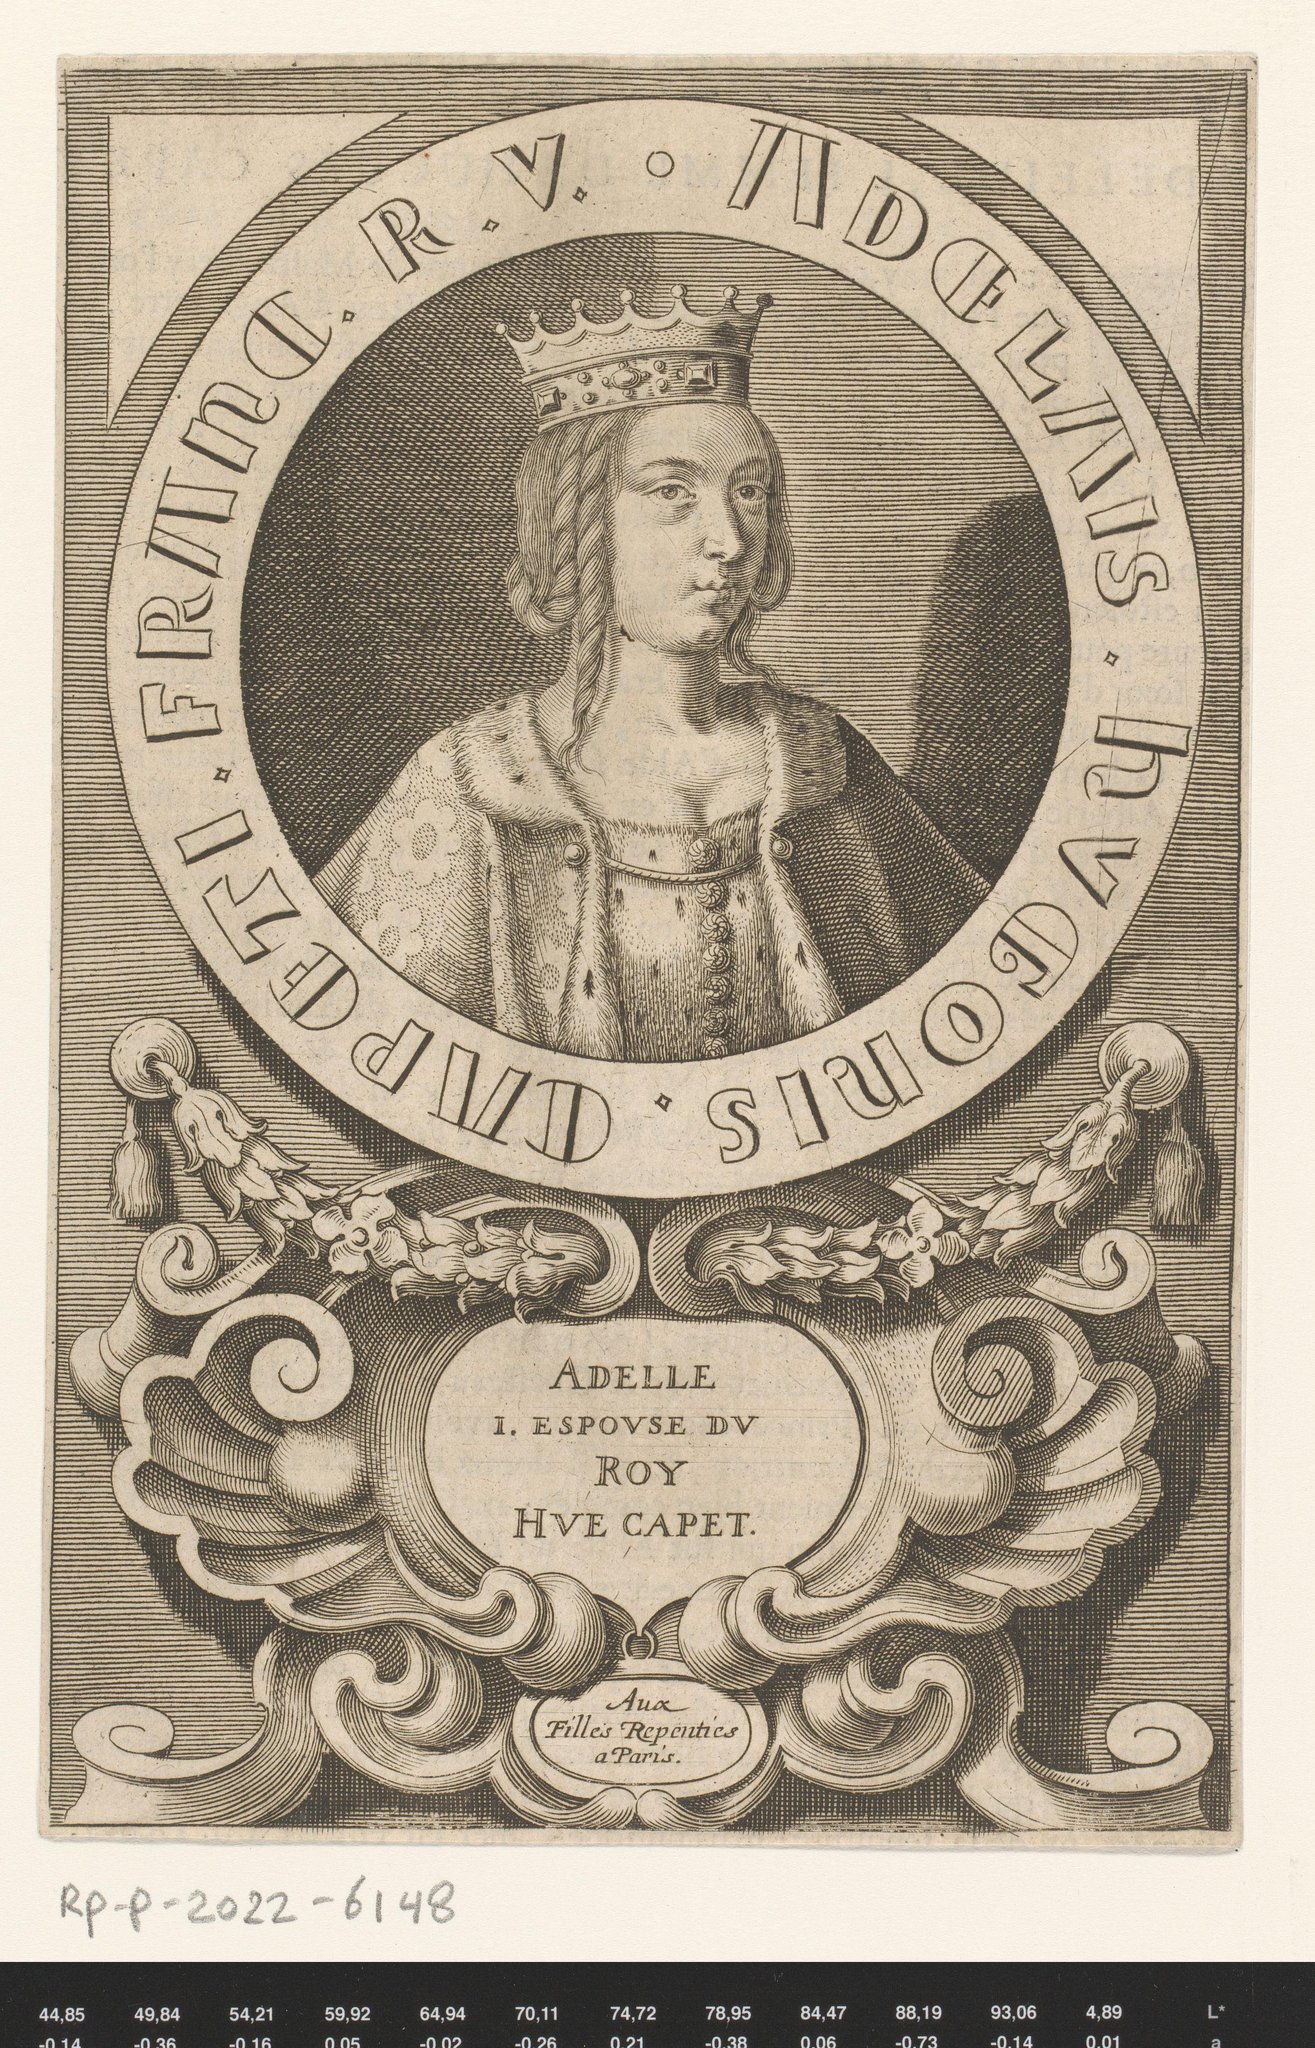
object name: book illustration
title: Portret van Adelheid van Tours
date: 1685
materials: paper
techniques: engraving, letterpress printing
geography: paris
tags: historical persons - bb - woman, king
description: Prent uit: Mézeray, François Eudes de. Histoire de France, depuis Faramond jusqu'au regne de Louis le Juste. (...) Parijs: Denis Thierry, Jean Guignard en Claude Barbin, 1685, dl. 2, p. 15.